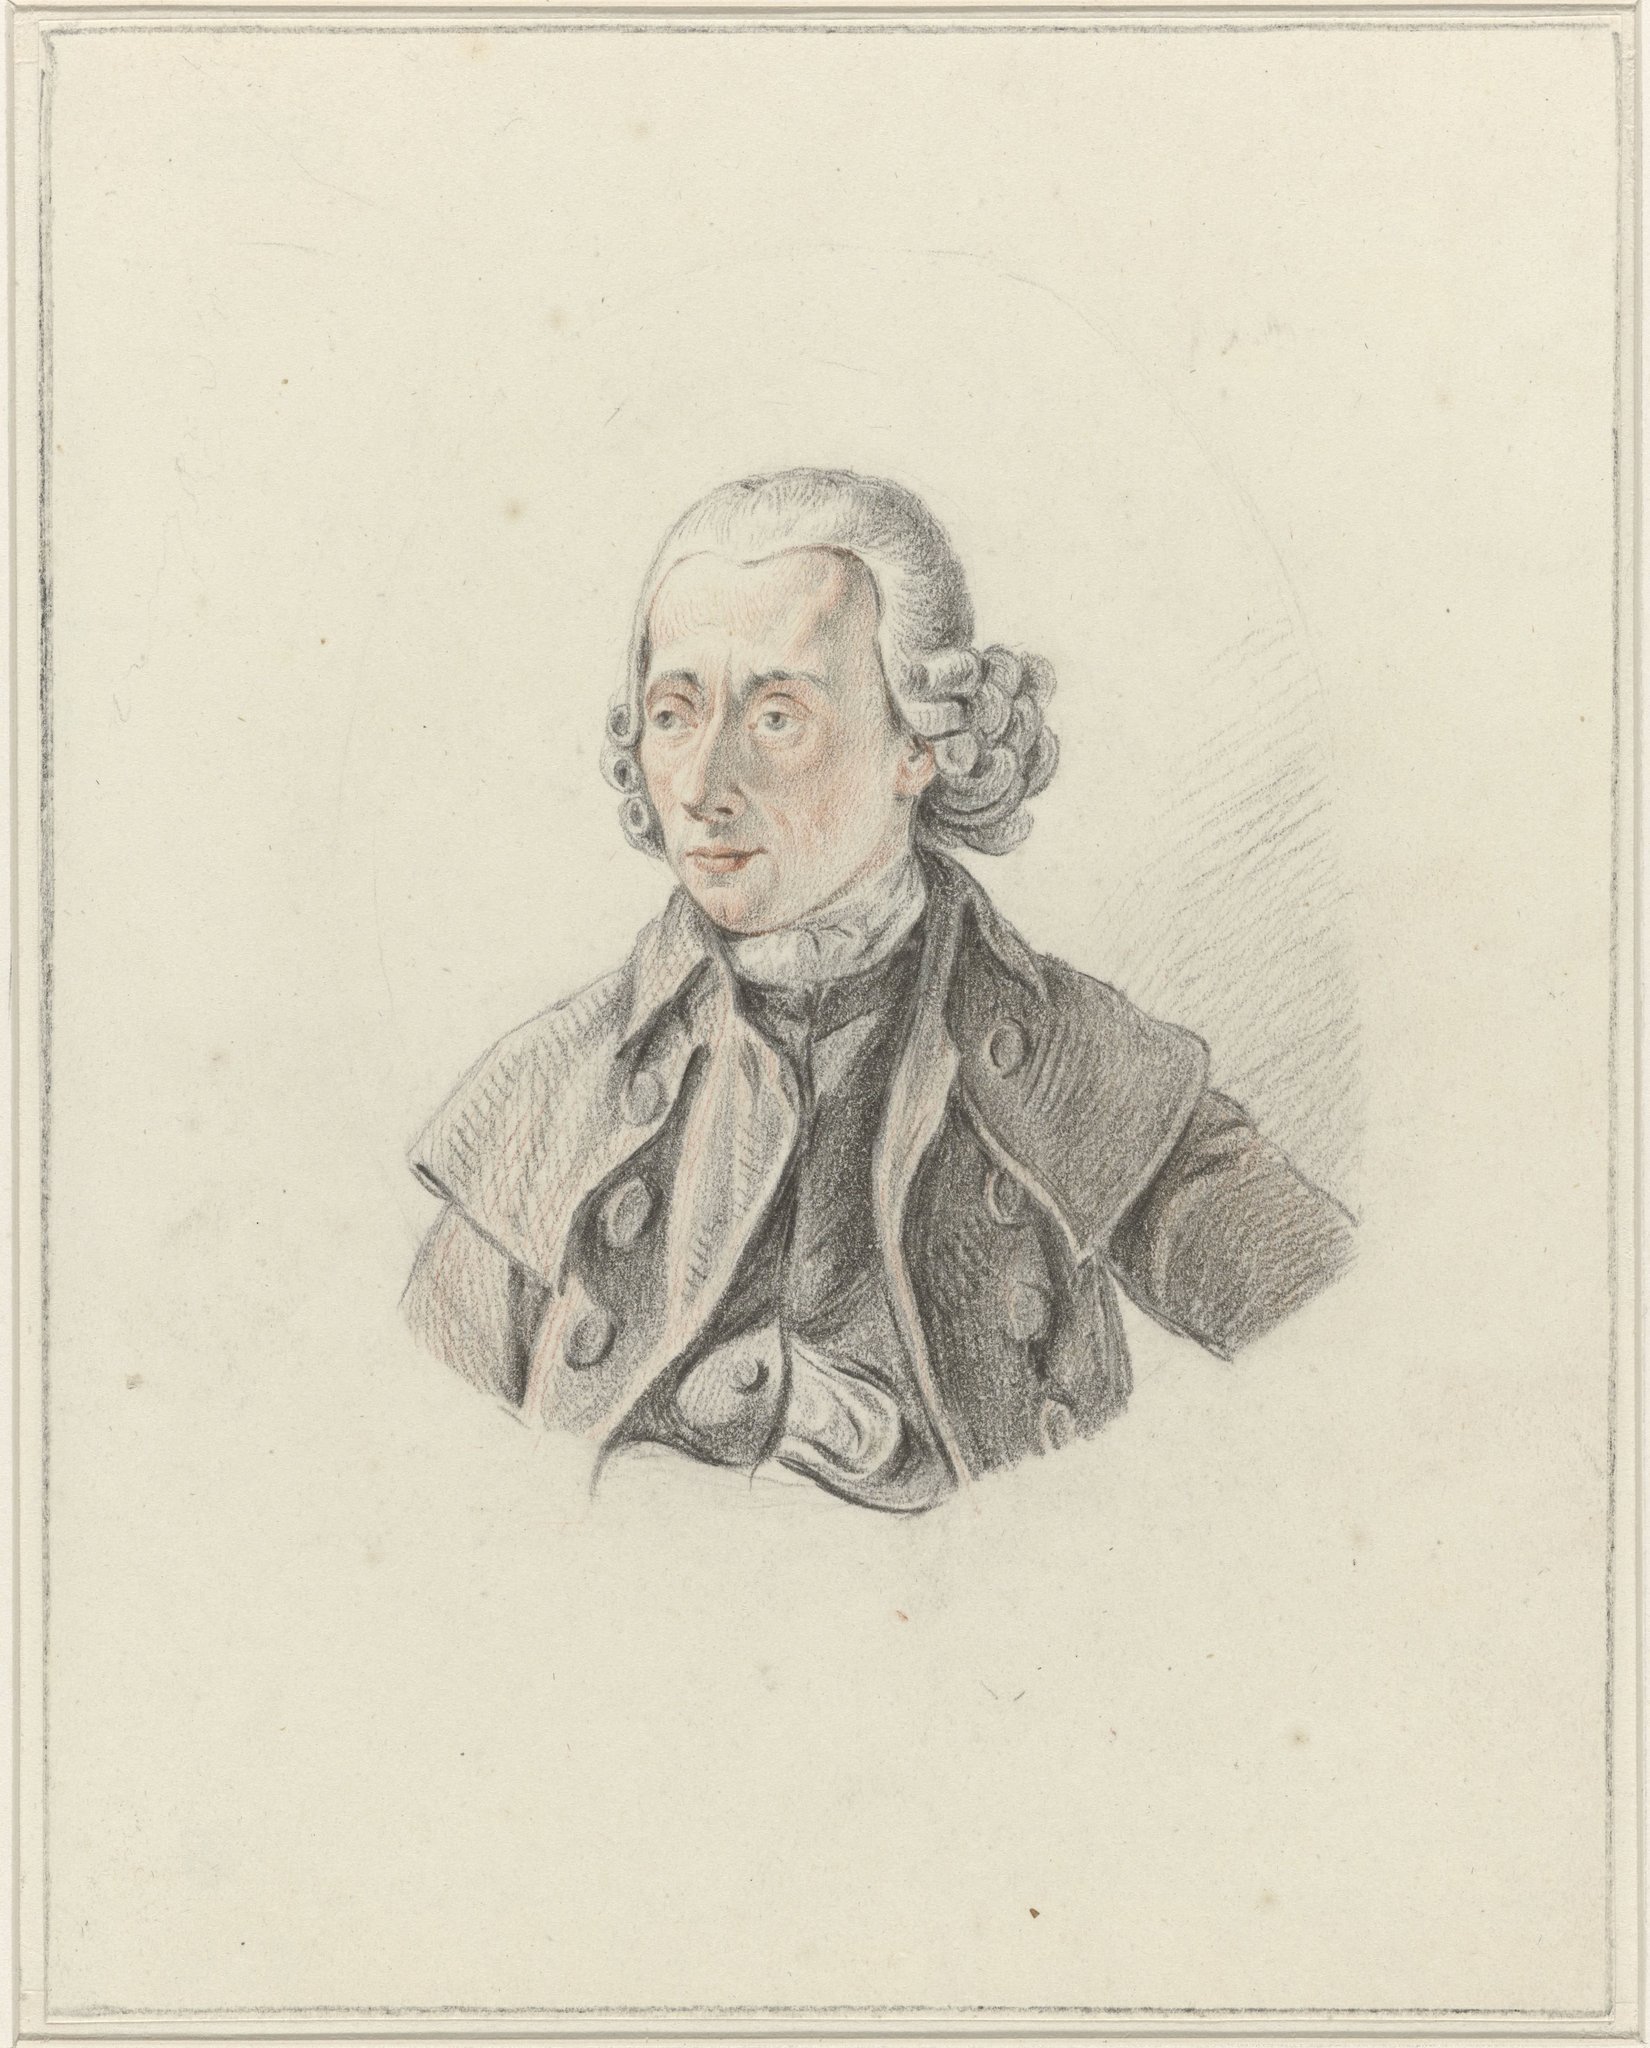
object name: drawing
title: Portret van Nicolaas Muys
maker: gerardus johannes verburgh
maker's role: draughtsman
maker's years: 1775-1864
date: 1785-1864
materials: chalk, paper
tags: painter, nicolaes muys, historical persons, portrait, self-portrait of artist